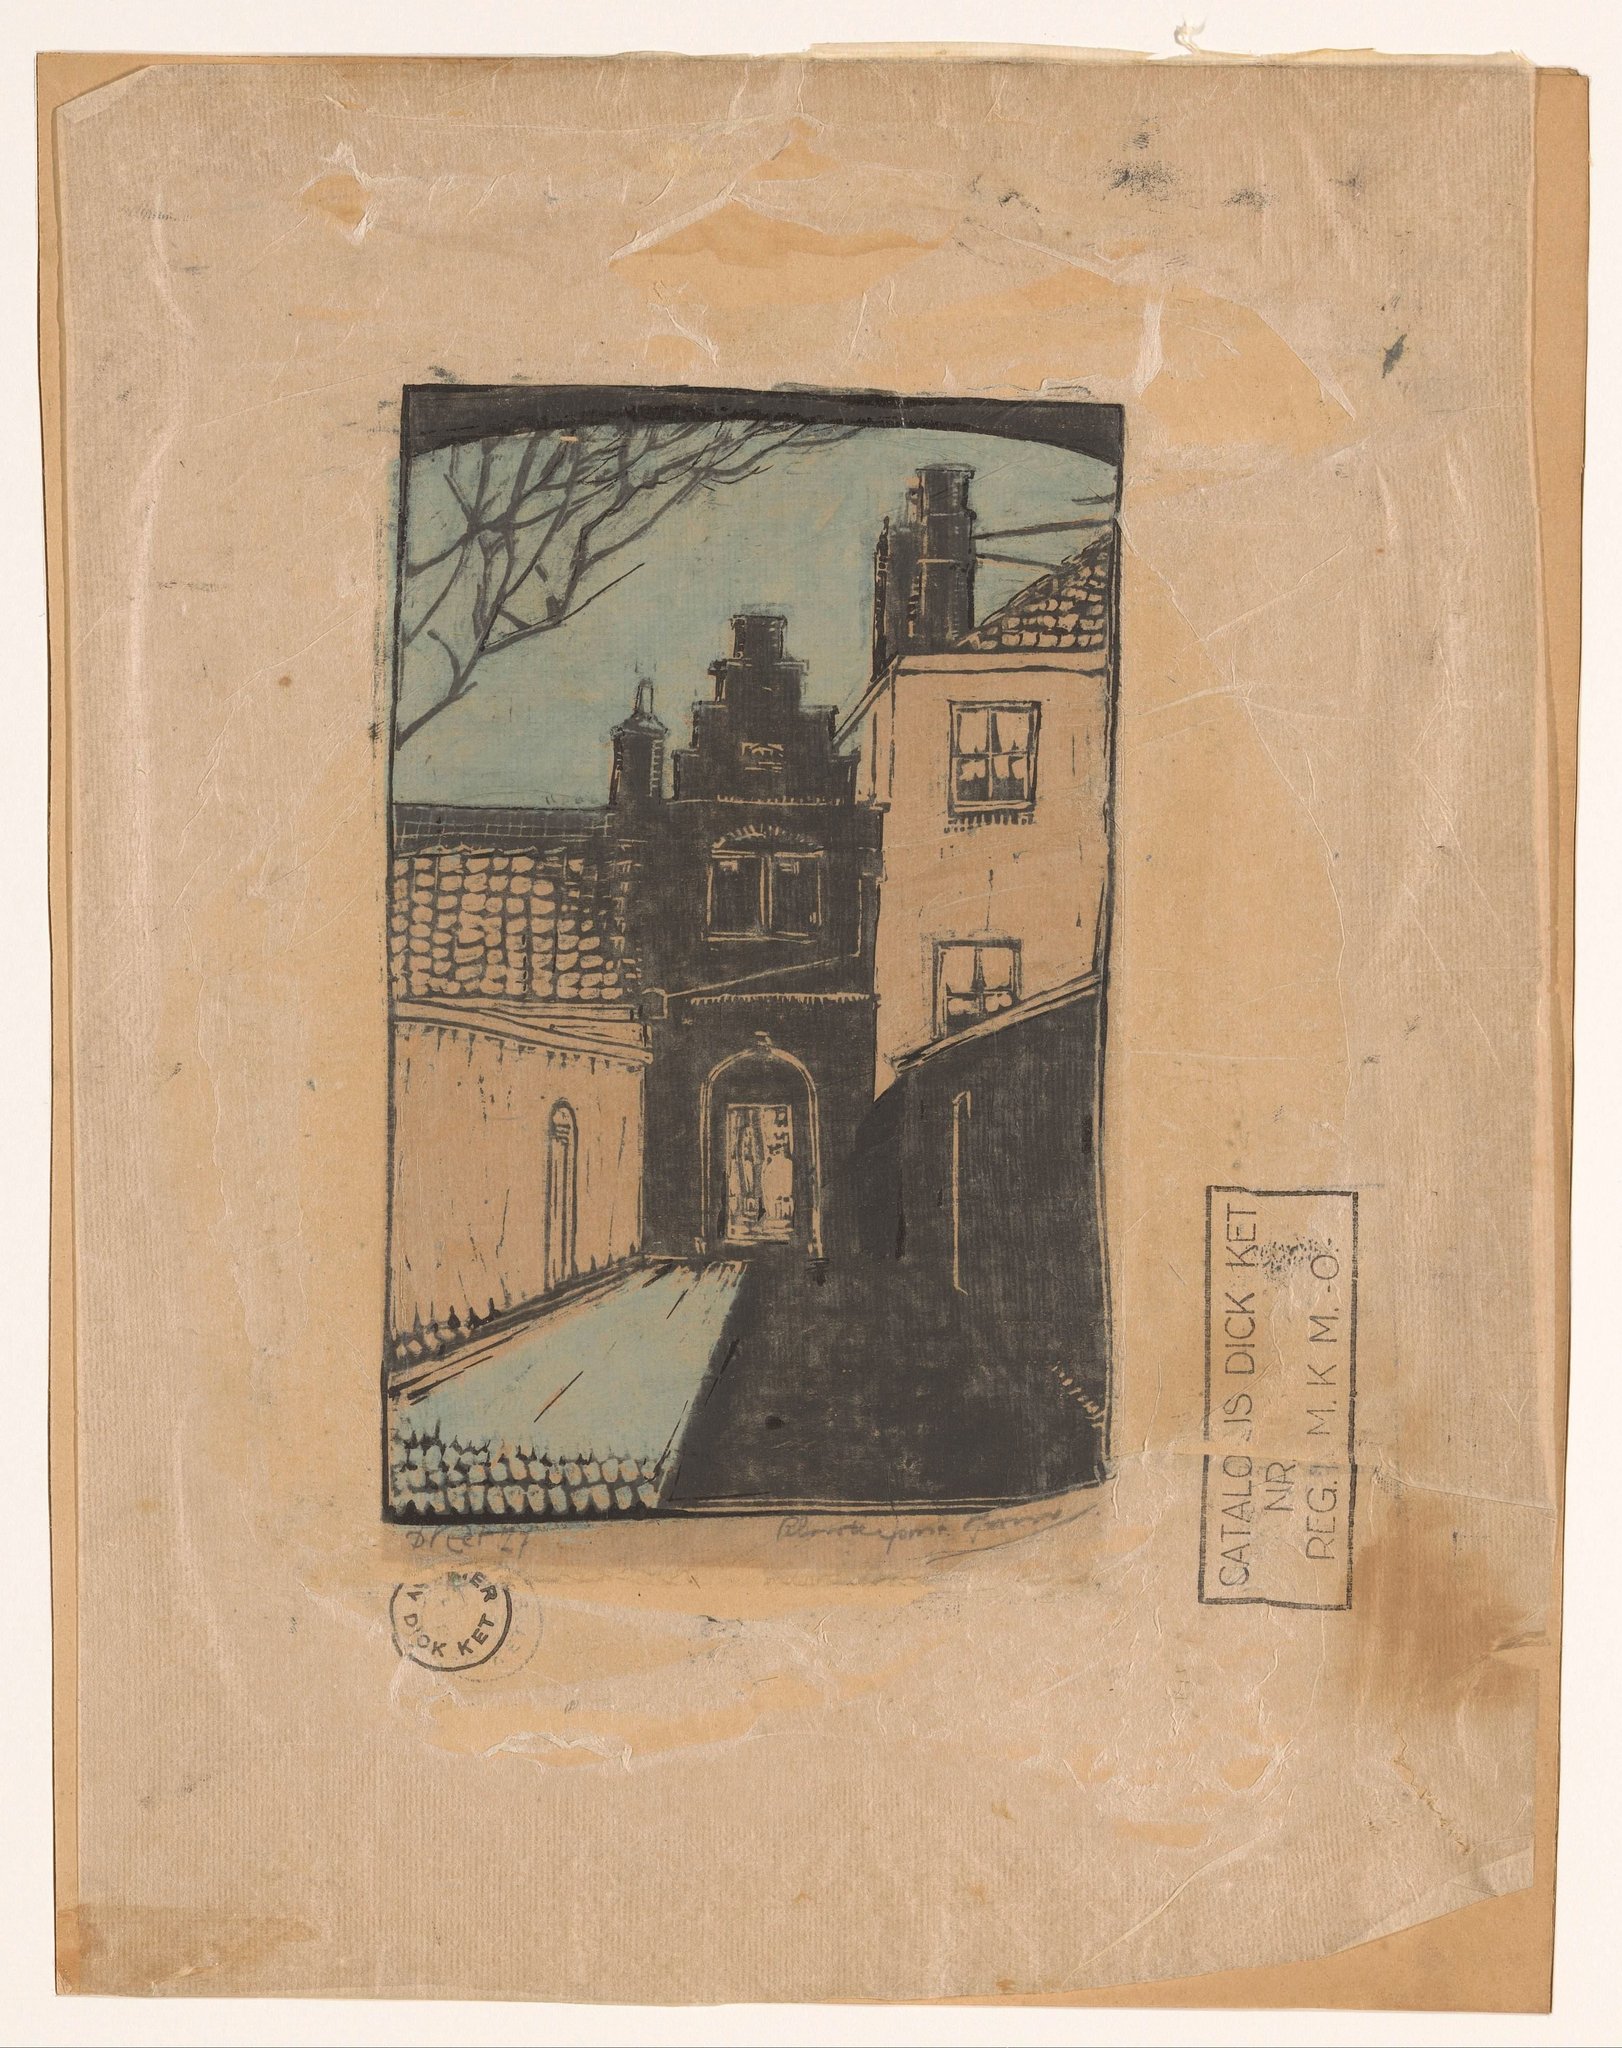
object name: print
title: Kloosterpoort, Hoorn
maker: dick ket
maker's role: draughtsman, print maker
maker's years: 1902-1940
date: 1927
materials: paper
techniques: hand coloring, linocut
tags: city-gate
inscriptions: workshop stamp: ‘ATELIER DICK KET’, collector's mark: Lugt 2228, stamp: ‘CATALO[...]US DICK KET / NR / REG. [...] M. K M. -O.-’, collector's mark: Lugt 2760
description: Een poort met trapgevel in het Noord-Hollandse Hoorn.